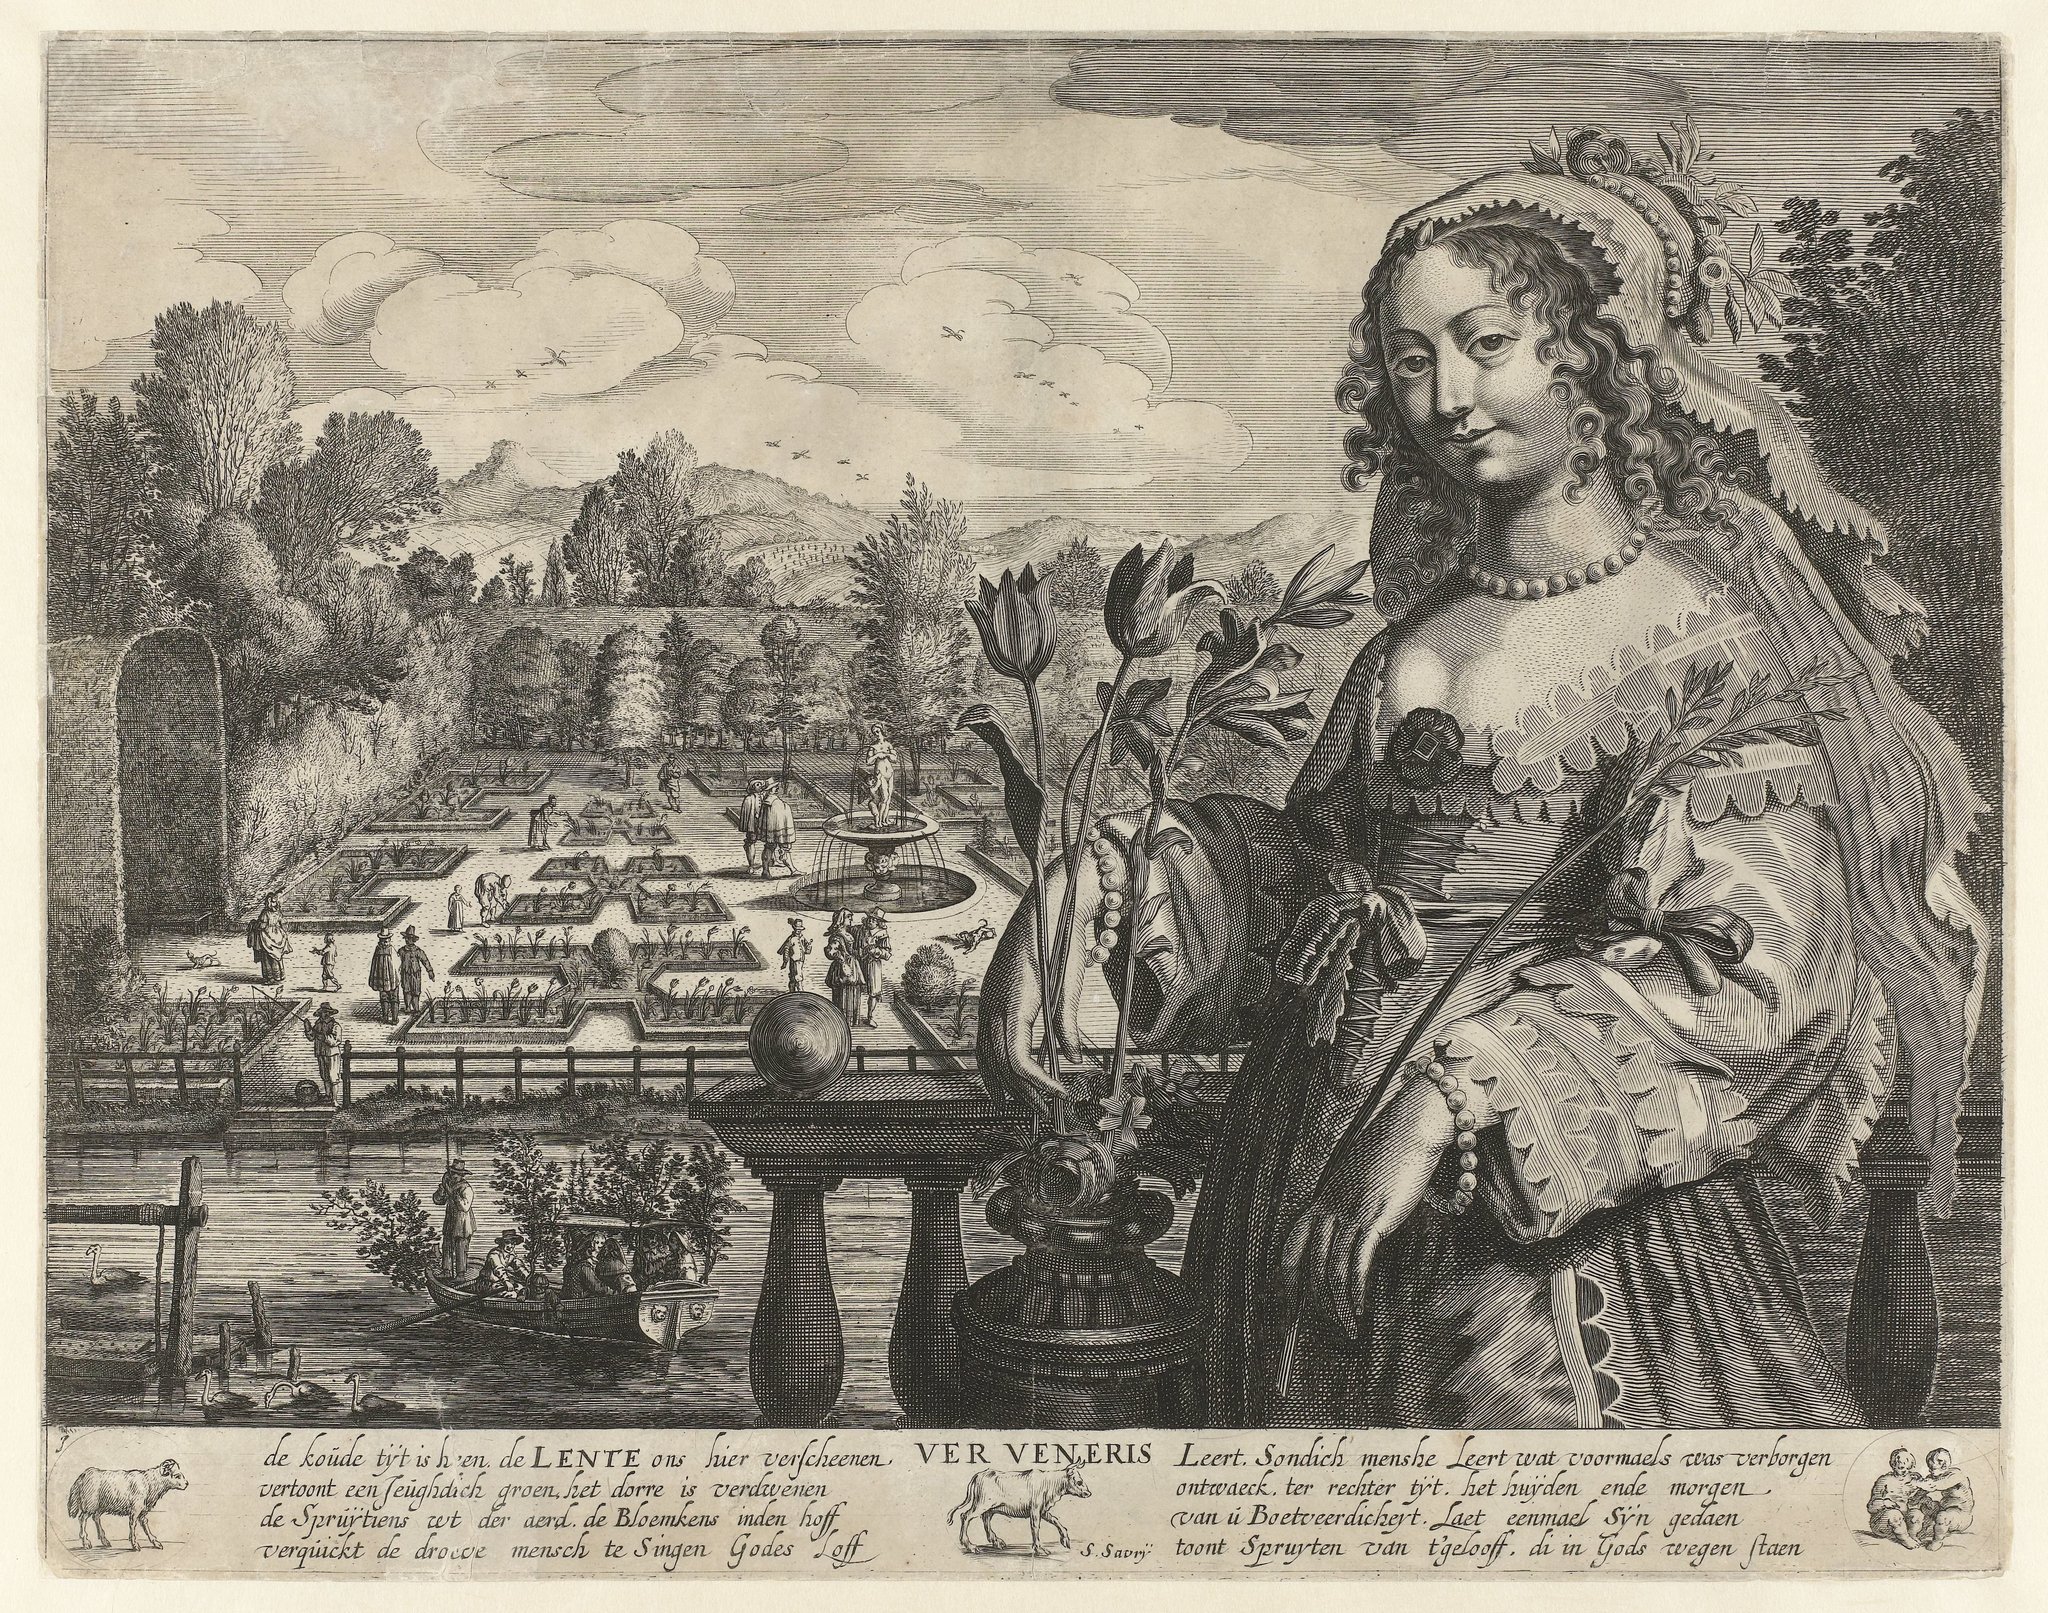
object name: print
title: Springtime (Ver Veneris)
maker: salomon savery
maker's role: print maker, publisher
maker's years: 1594-1683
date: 1604-1683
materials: paper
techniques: engraving, etching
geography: amsterdam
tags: spring ~ human activities (the four seasons of the year), zodiacal signs of the spring season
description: Een jonge vrouw staat bij een vaas met tulpen op een balustrade. Op de achtergrond een tuin met een Venusfontein en wandelende figuren. Op het water varen mensen in een met takken versierde roeiboot. Onder de prent een achtregelig gedicht, in twee kolommen, en de tekens van de sterrenbeelden ram, stier en tweelingen.